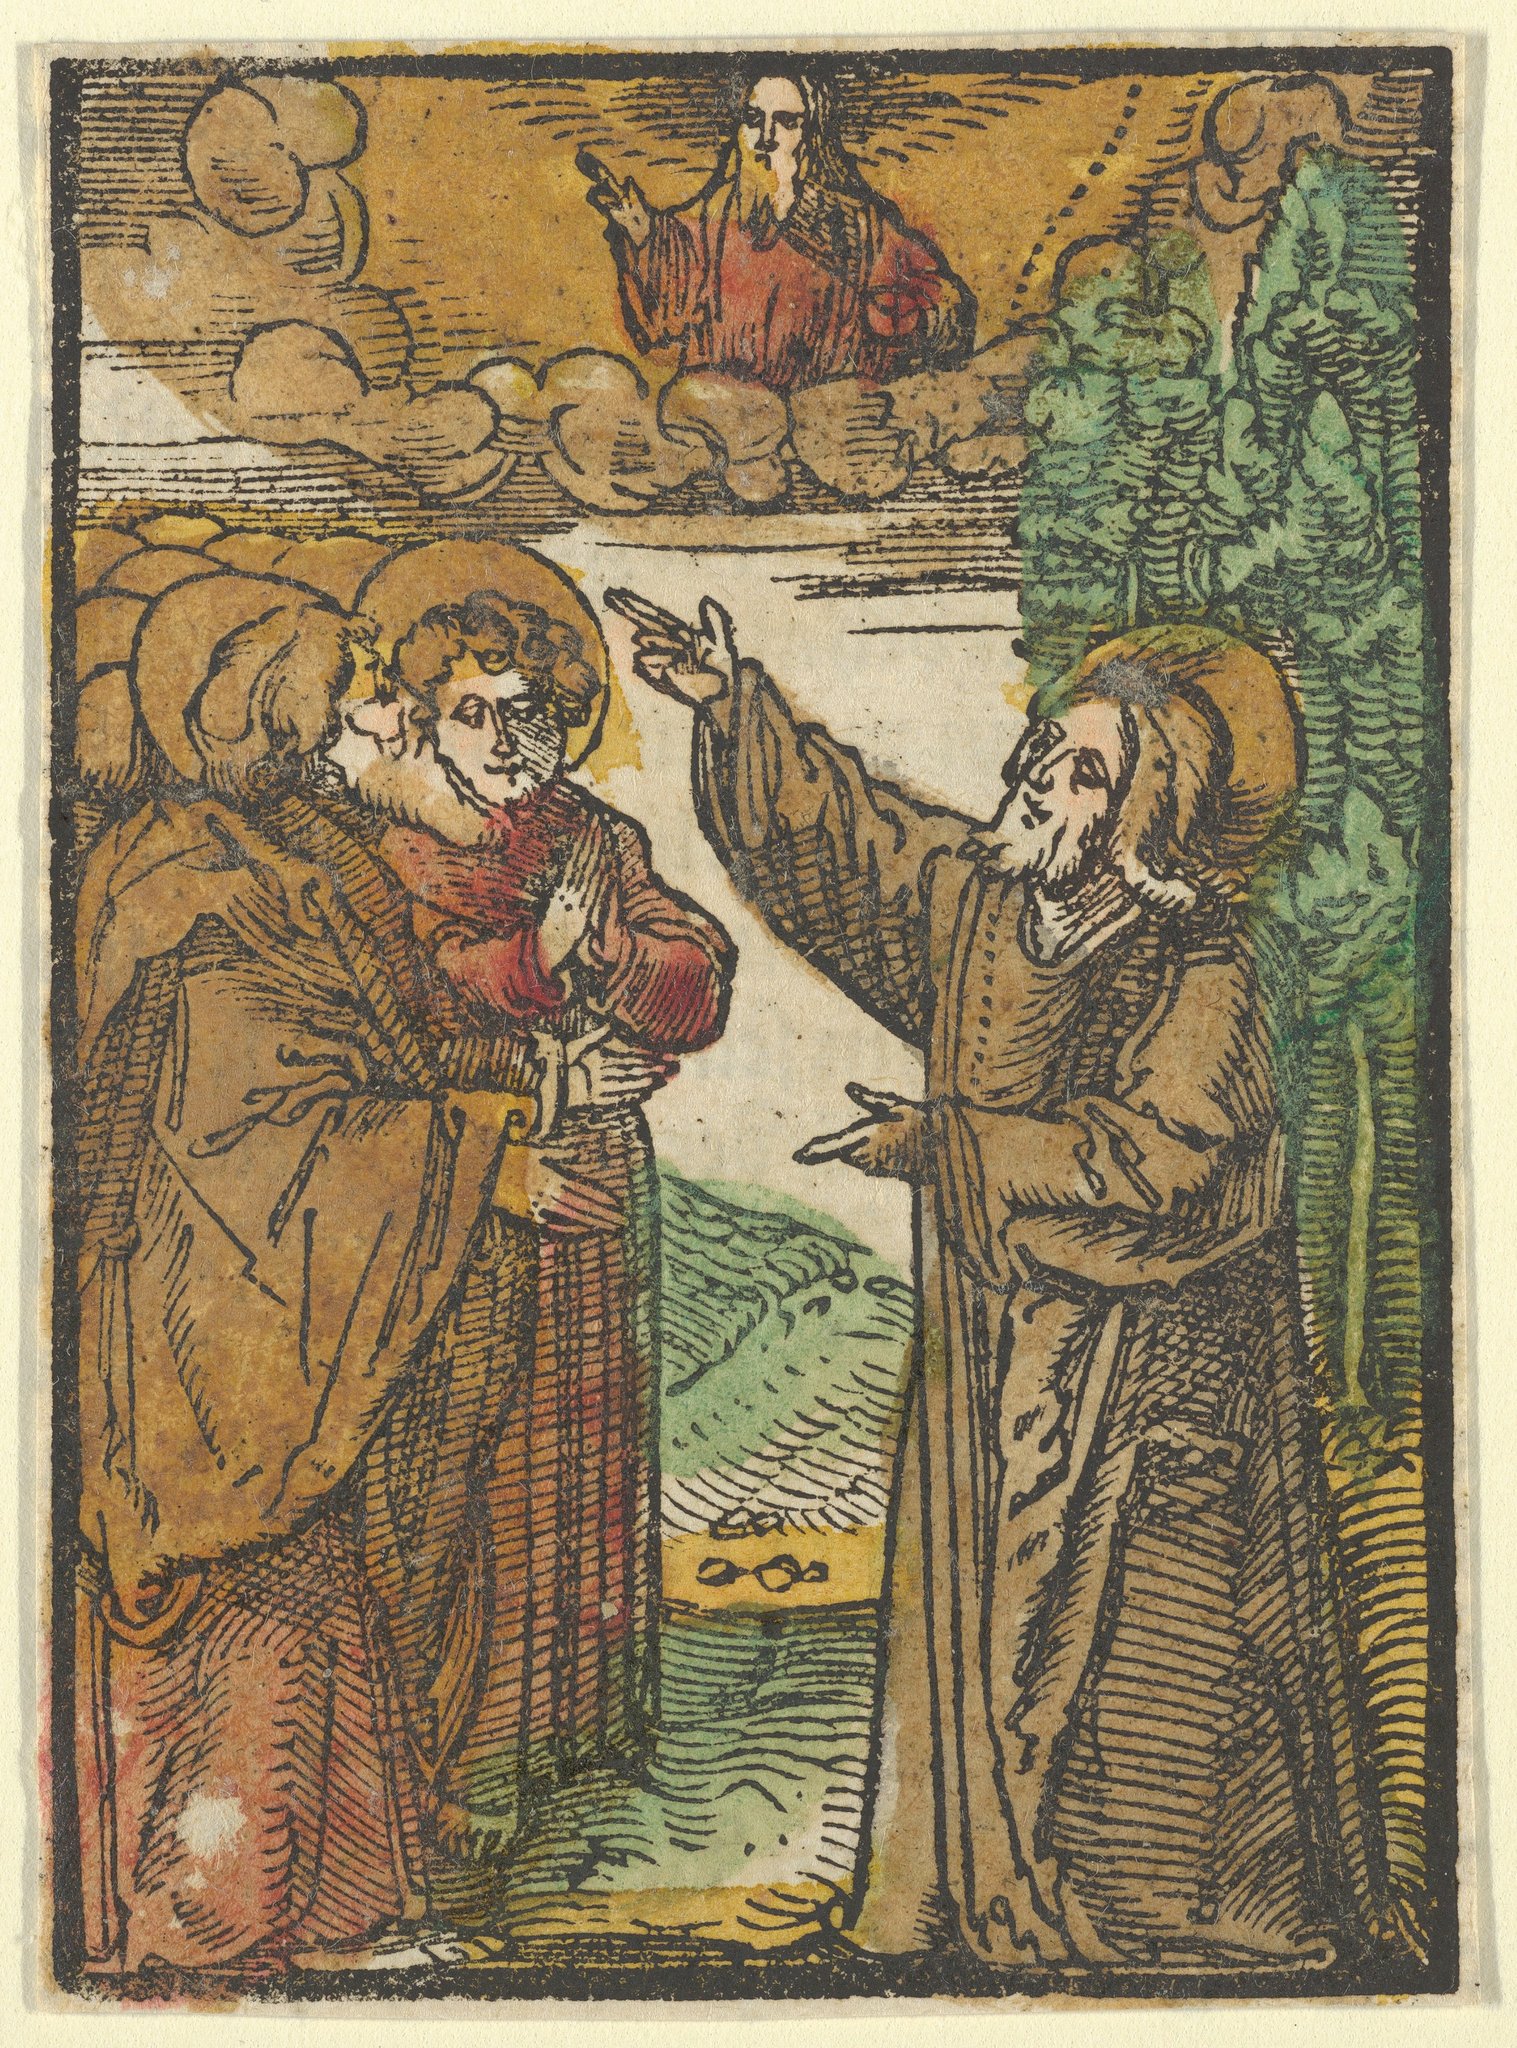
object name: print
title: Christ Talking about his Return to the Father, from Das Plenarium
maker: hans schäufelein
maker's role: artist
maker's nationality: german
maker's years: 1480-1540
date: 1517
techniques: hand coloring, woodcut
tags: men,christ